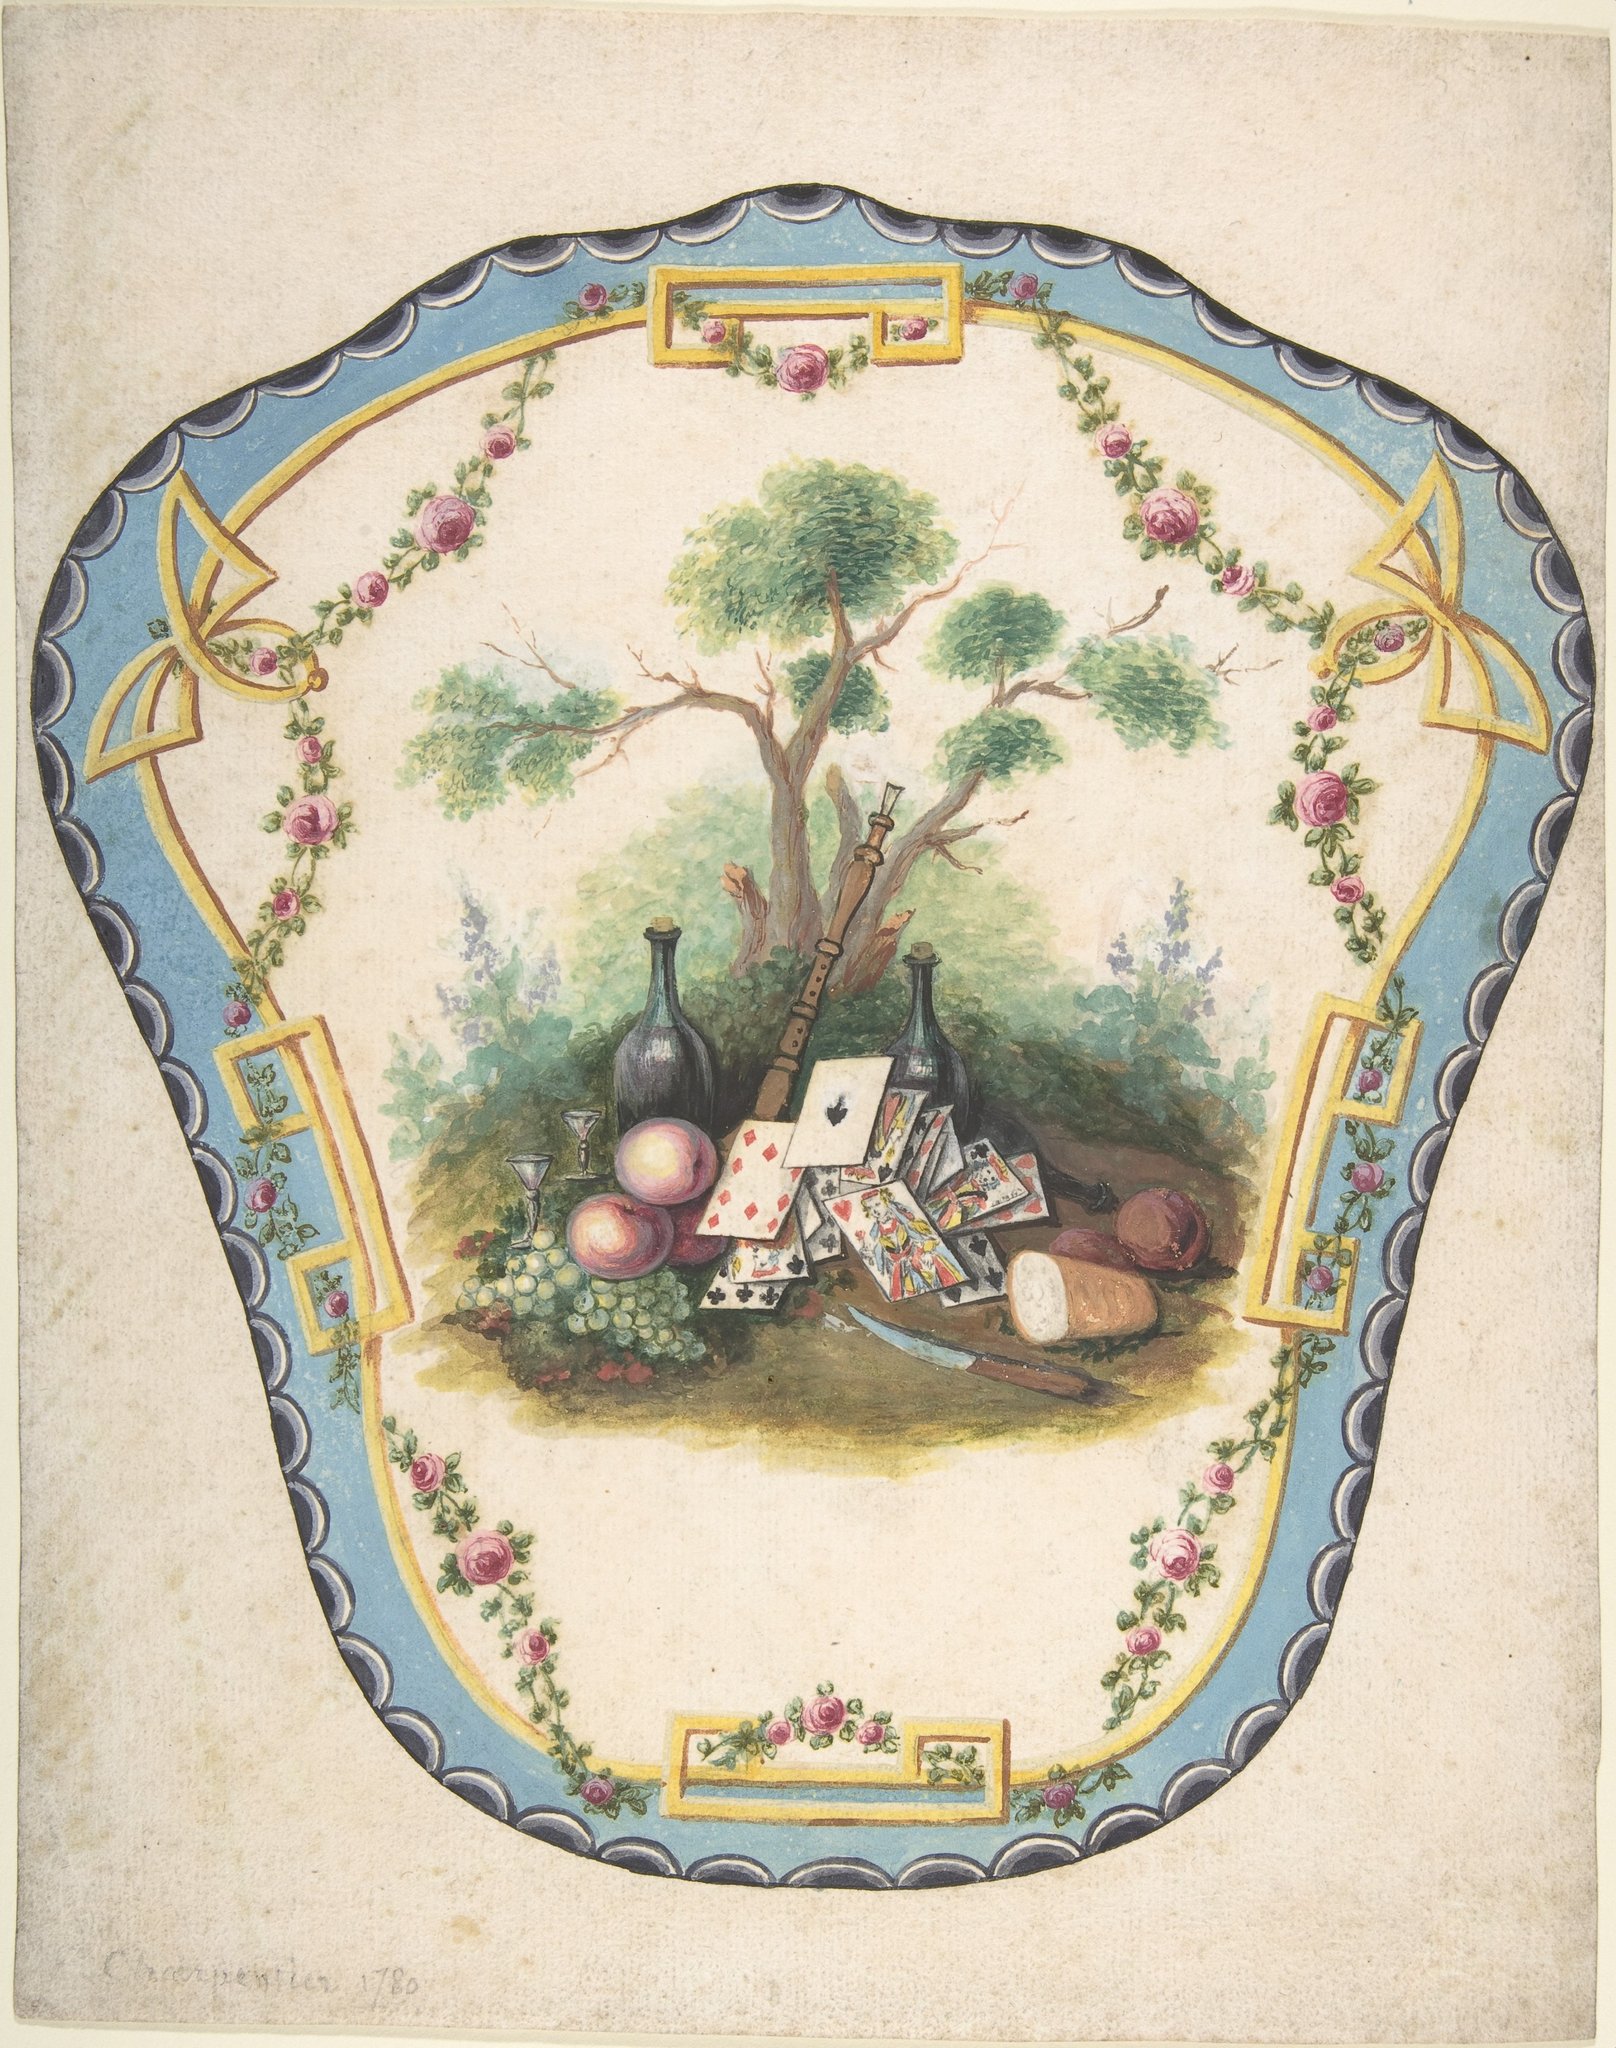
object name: drawing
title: Design for a Firescreen with Picnic Scene and Playing Cards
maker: eugène charpentier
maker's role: artist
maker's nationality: french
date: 1767-1800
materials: gouache, graphite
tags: bread,grapes,playing cards